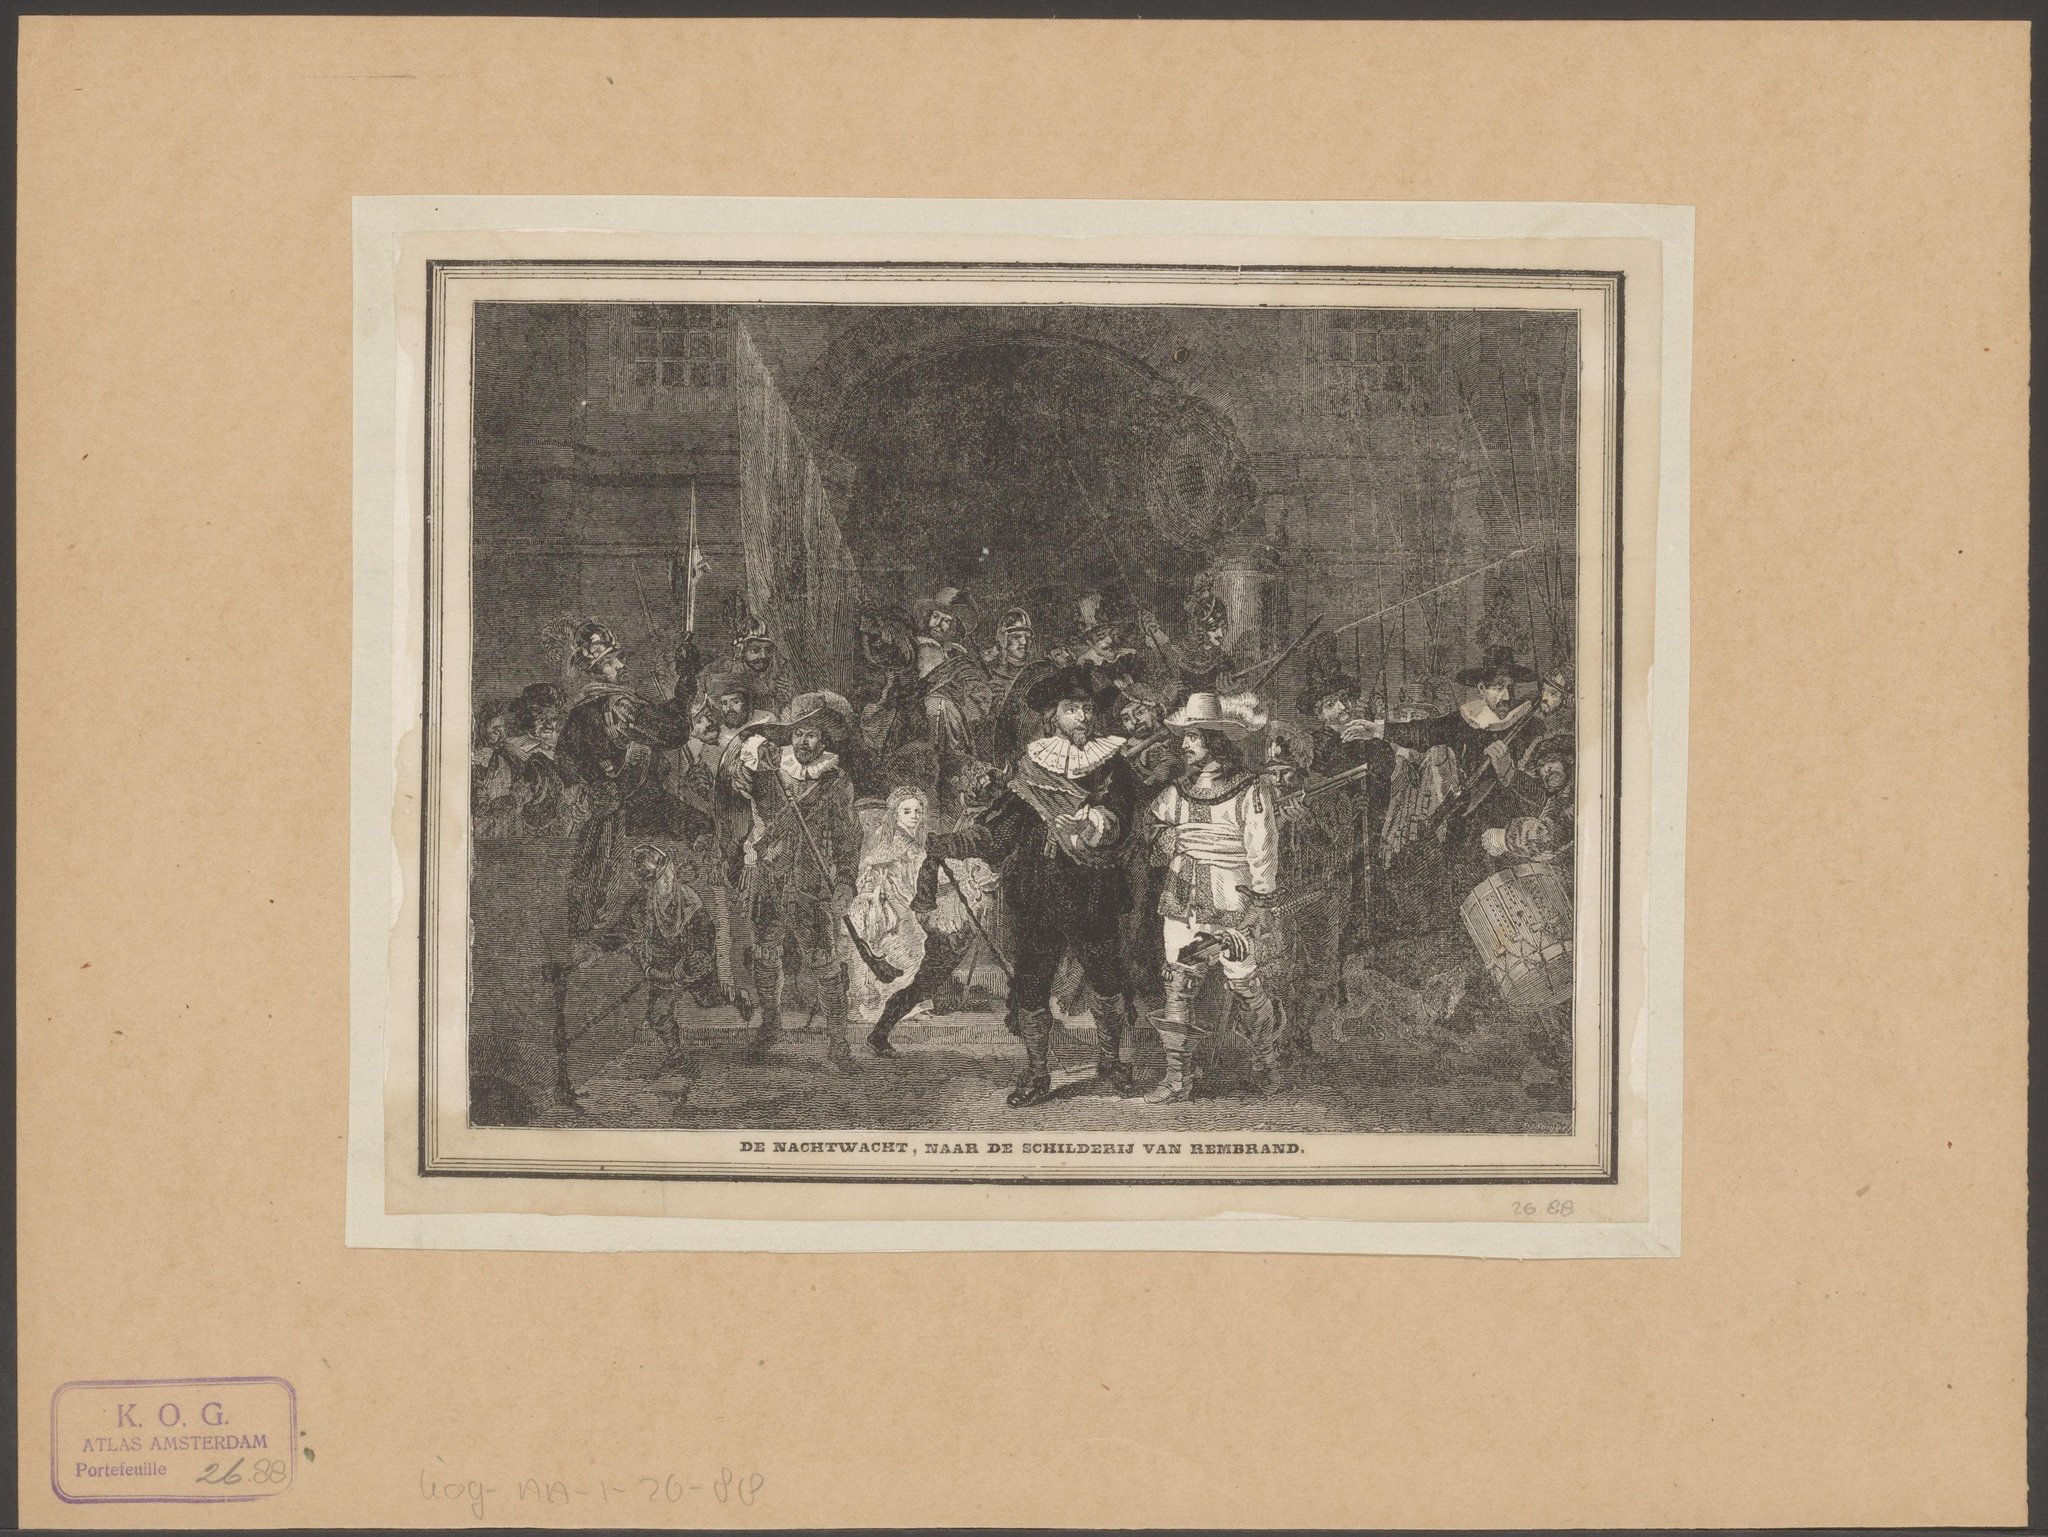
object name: print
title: De Nachtwacht, naar de schilderij van Rembrand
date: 1821-1886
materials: paper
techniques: letterpress printing, engraving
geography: amsterdam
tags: frans banninck cocq, amsterdam, historical persons, (military) standard-bearer, weapons, warfare; military affairs (+ citizen soldiery, civil guard, citizen militia)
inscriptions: collector's mark: Lugt 1641b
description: Onderwerpsrubriek binnen de Atlas Amsterdam: Herinneringen aan de Schutterij.